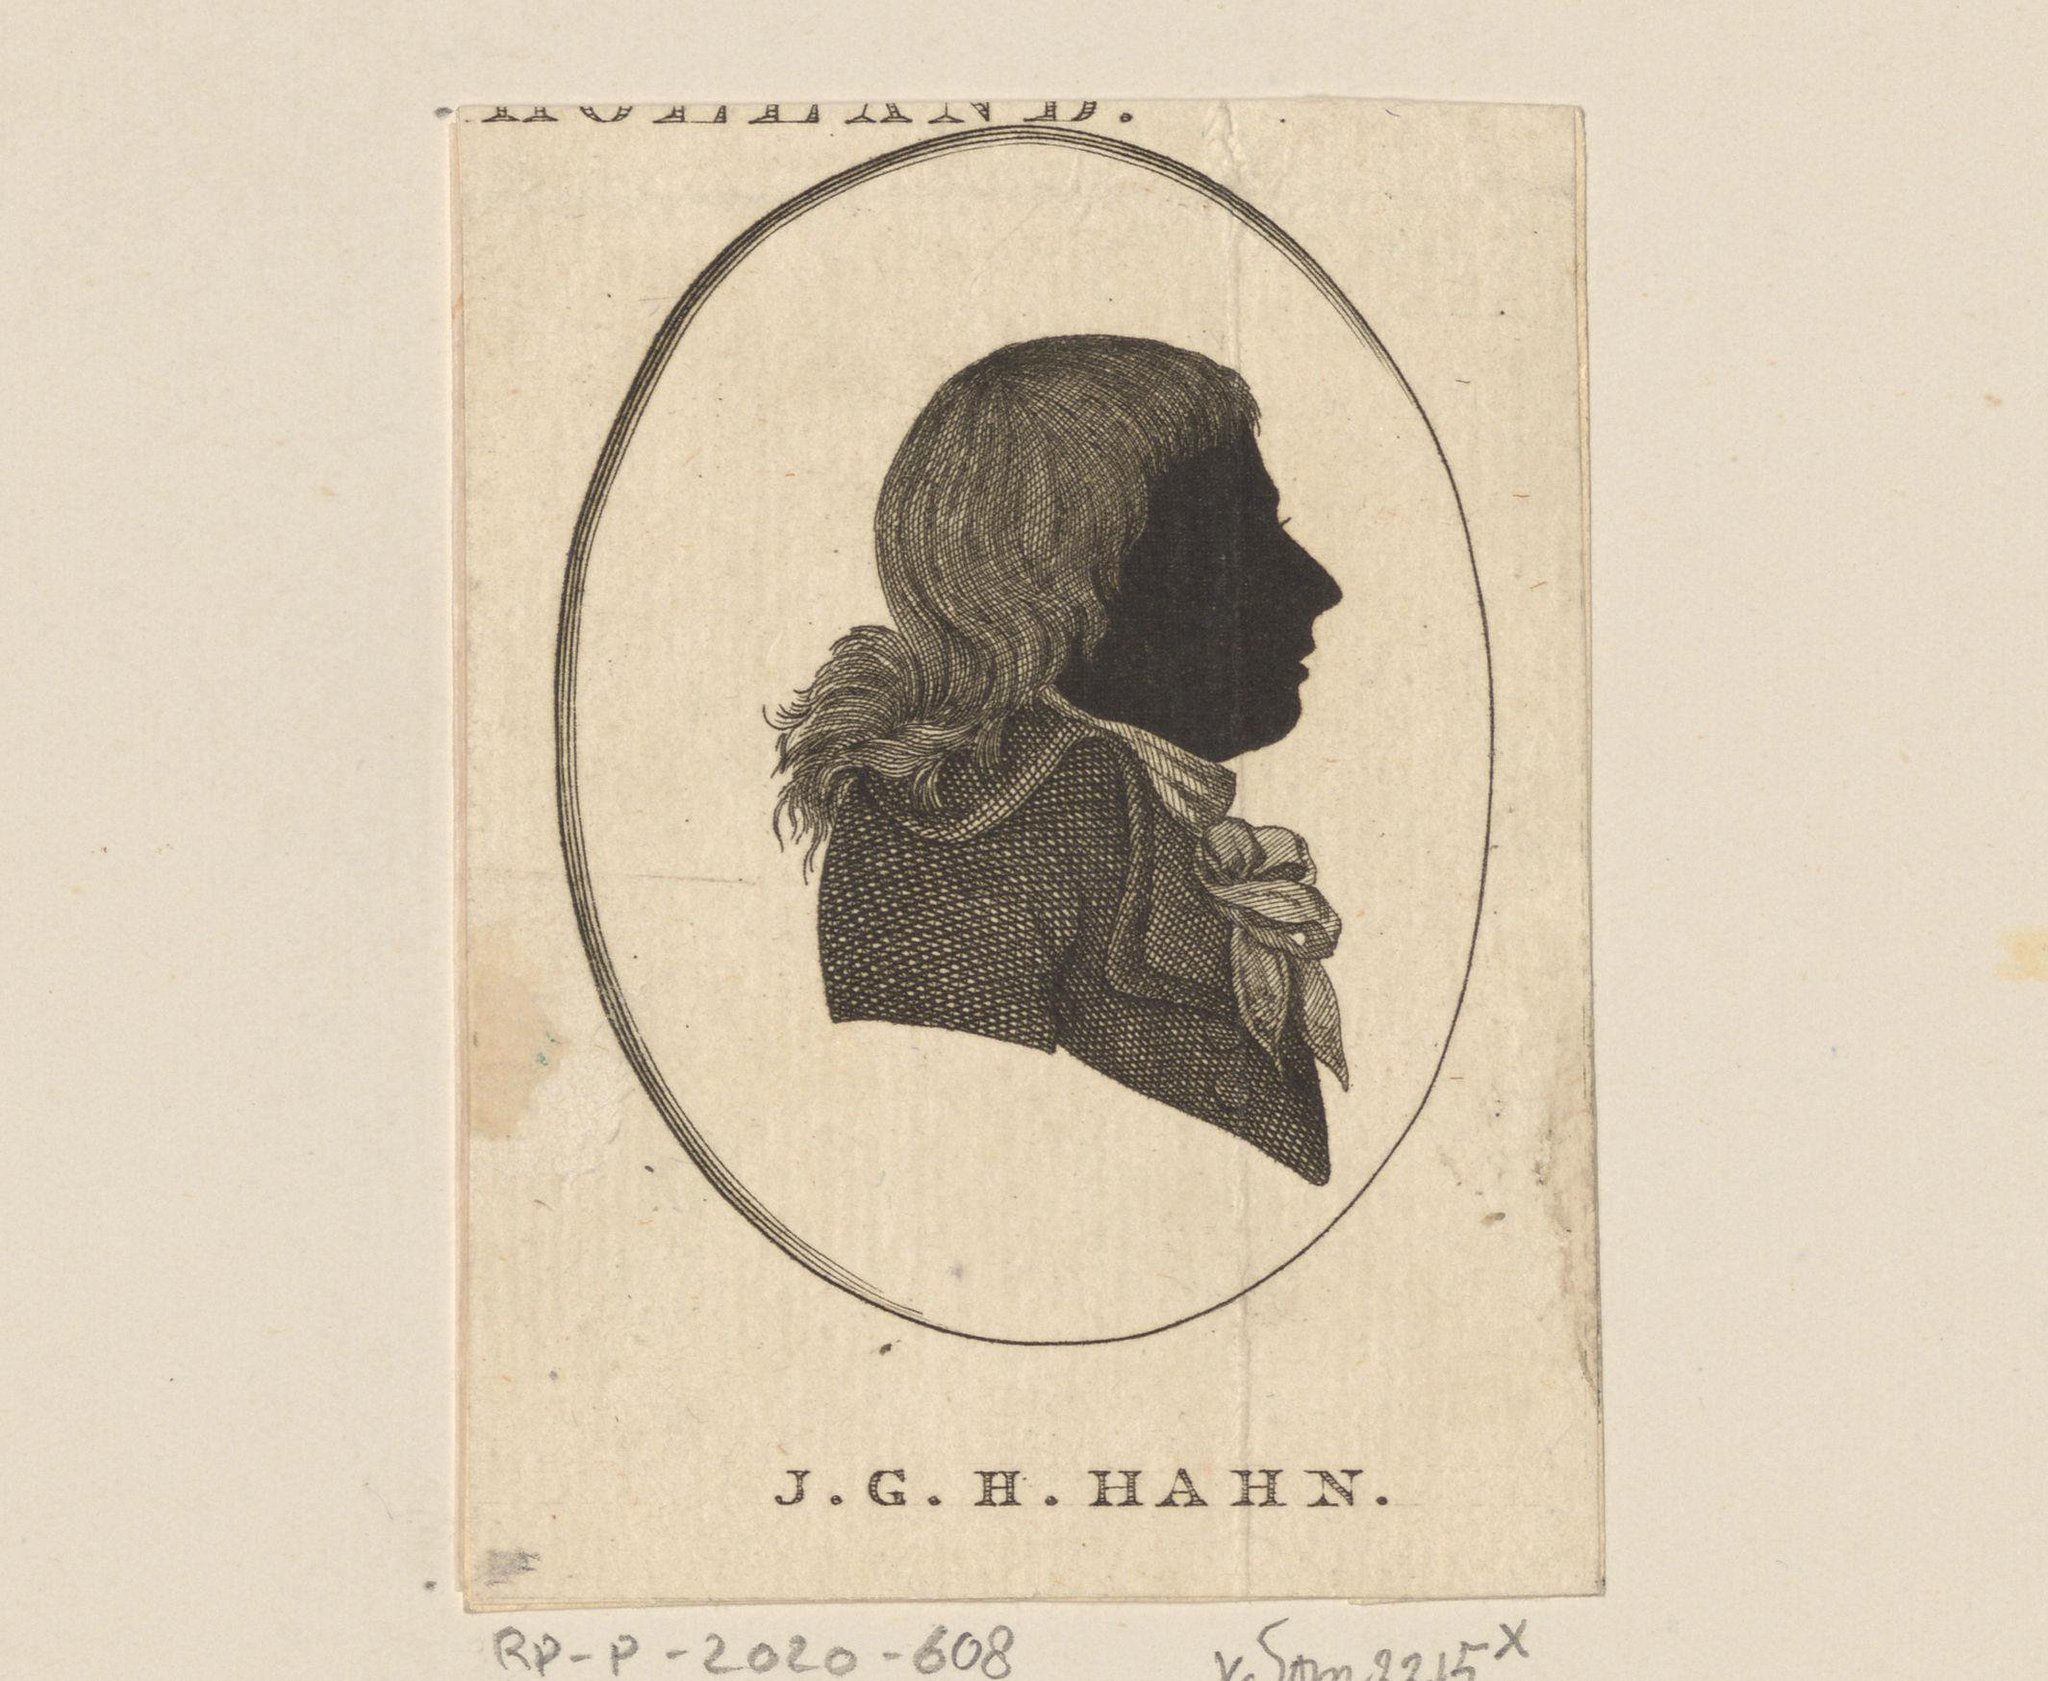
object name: print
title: Silhouetportret van Jacob George Jeronimo Hahn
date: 1799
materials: paper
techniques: etching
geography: amsterdam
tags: utrecht, haarlem, politician, historical persons, politician, e.g. party leader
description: Prent uit: Rogge, Cornelis. Geschiedenis der staatsregeling, voor het Bataafsche volk. Amsterdam: Johannes Allart, 1799.